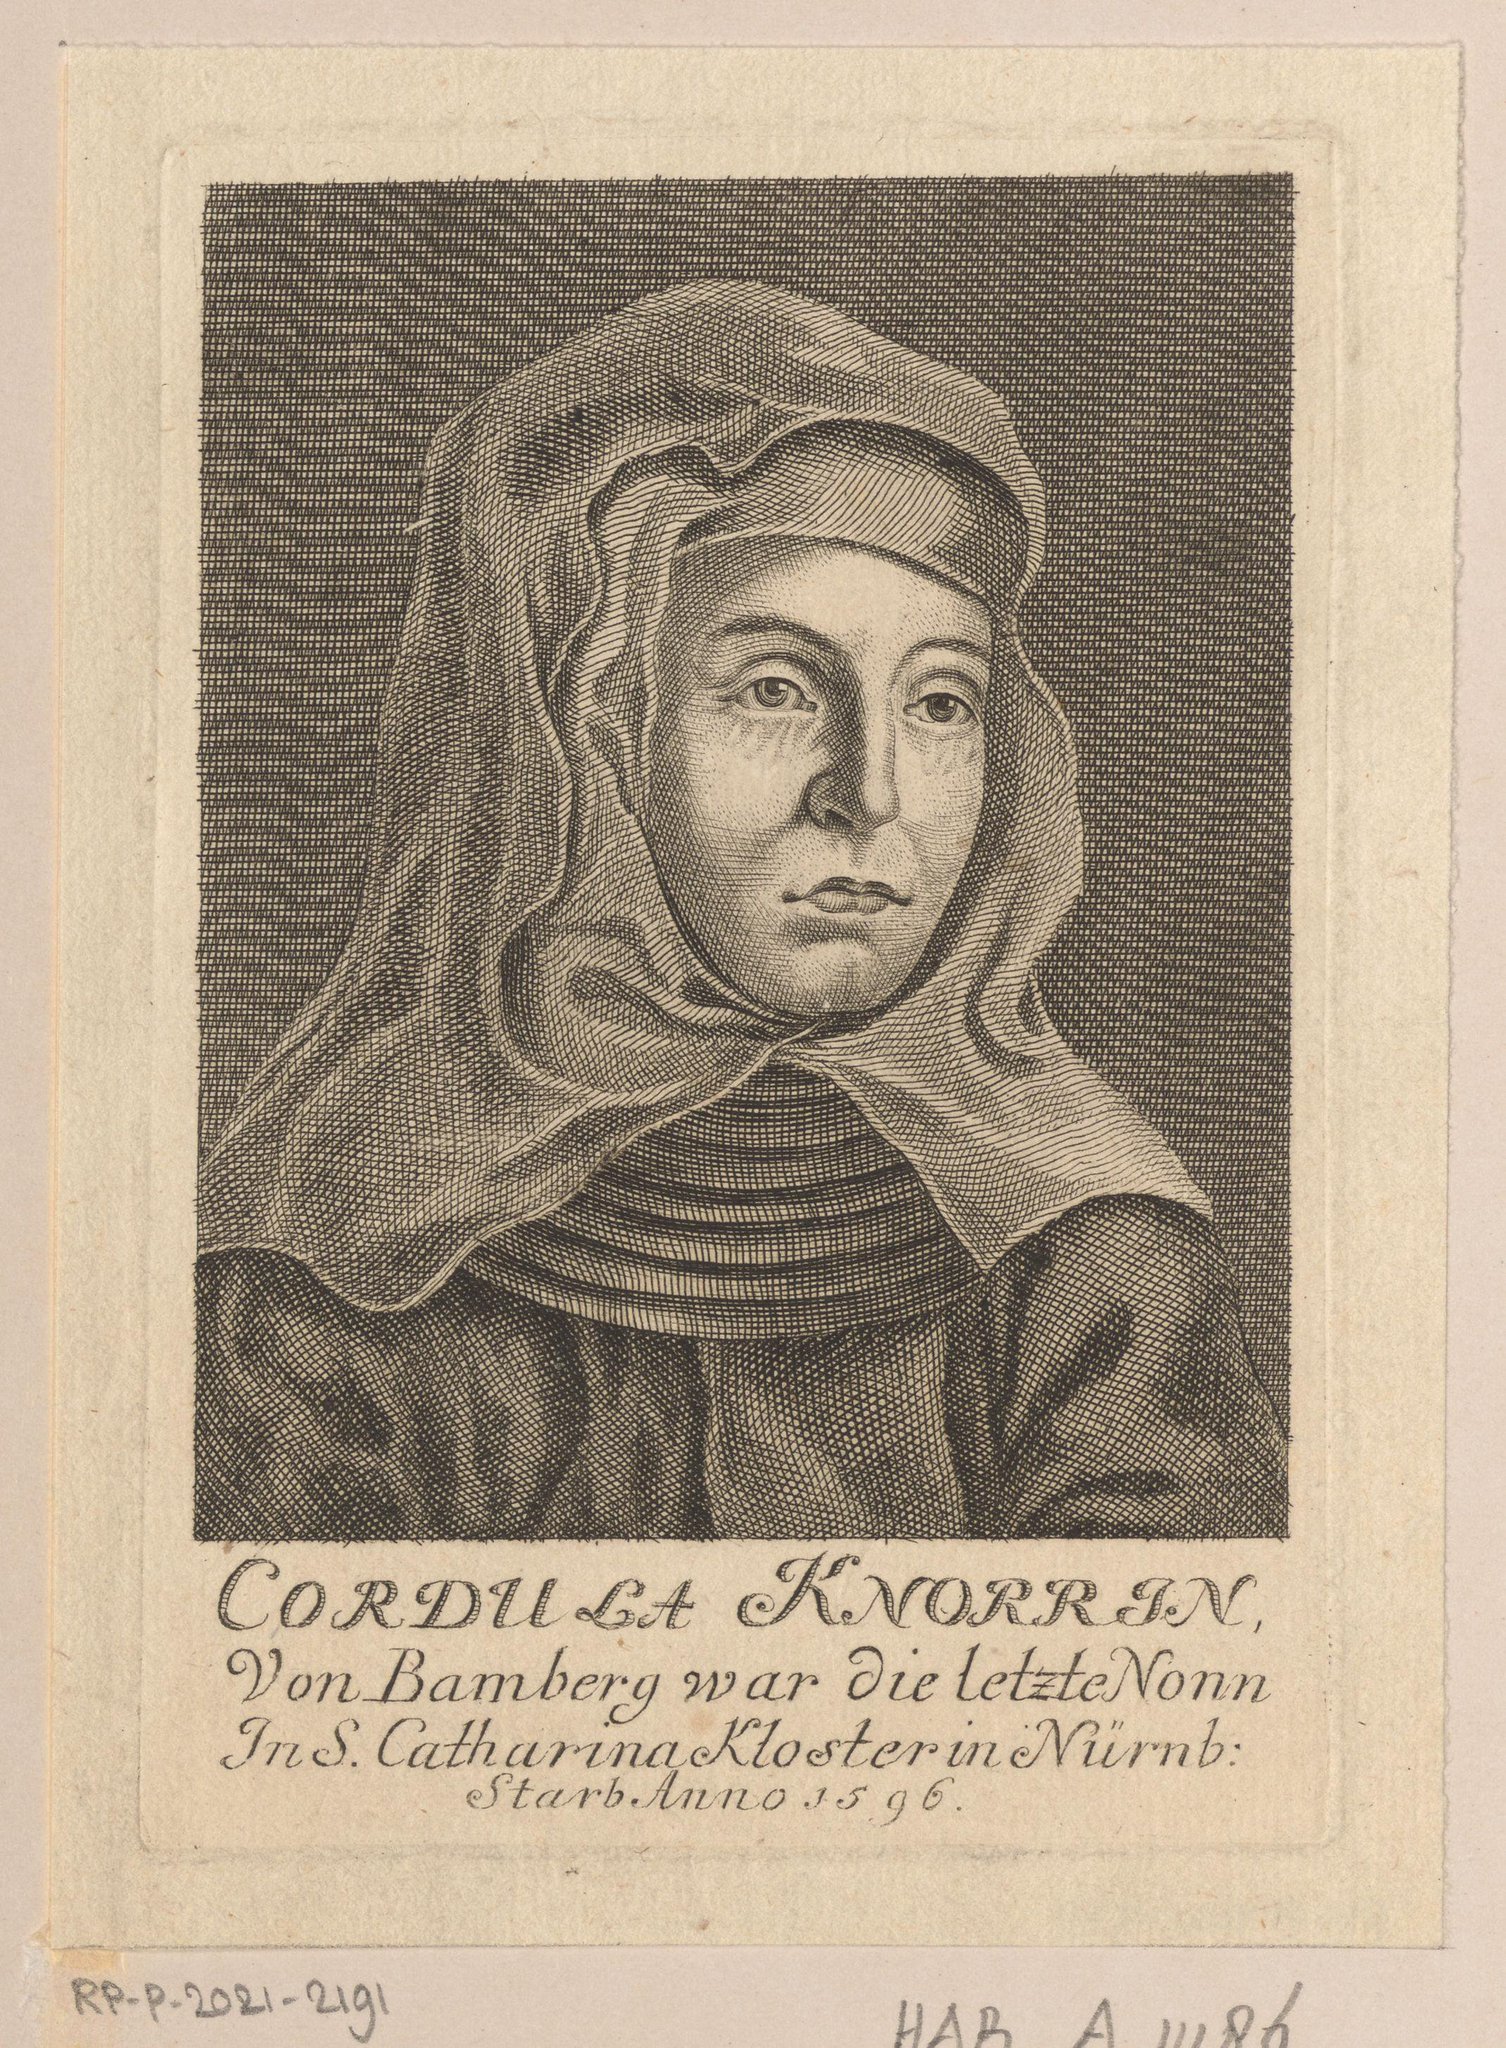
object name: print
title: Portret van Cordula Knorr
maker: Anonymous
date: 1596-1724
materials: paper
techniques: engraving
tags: historical persons - bb - woman, nun(s)